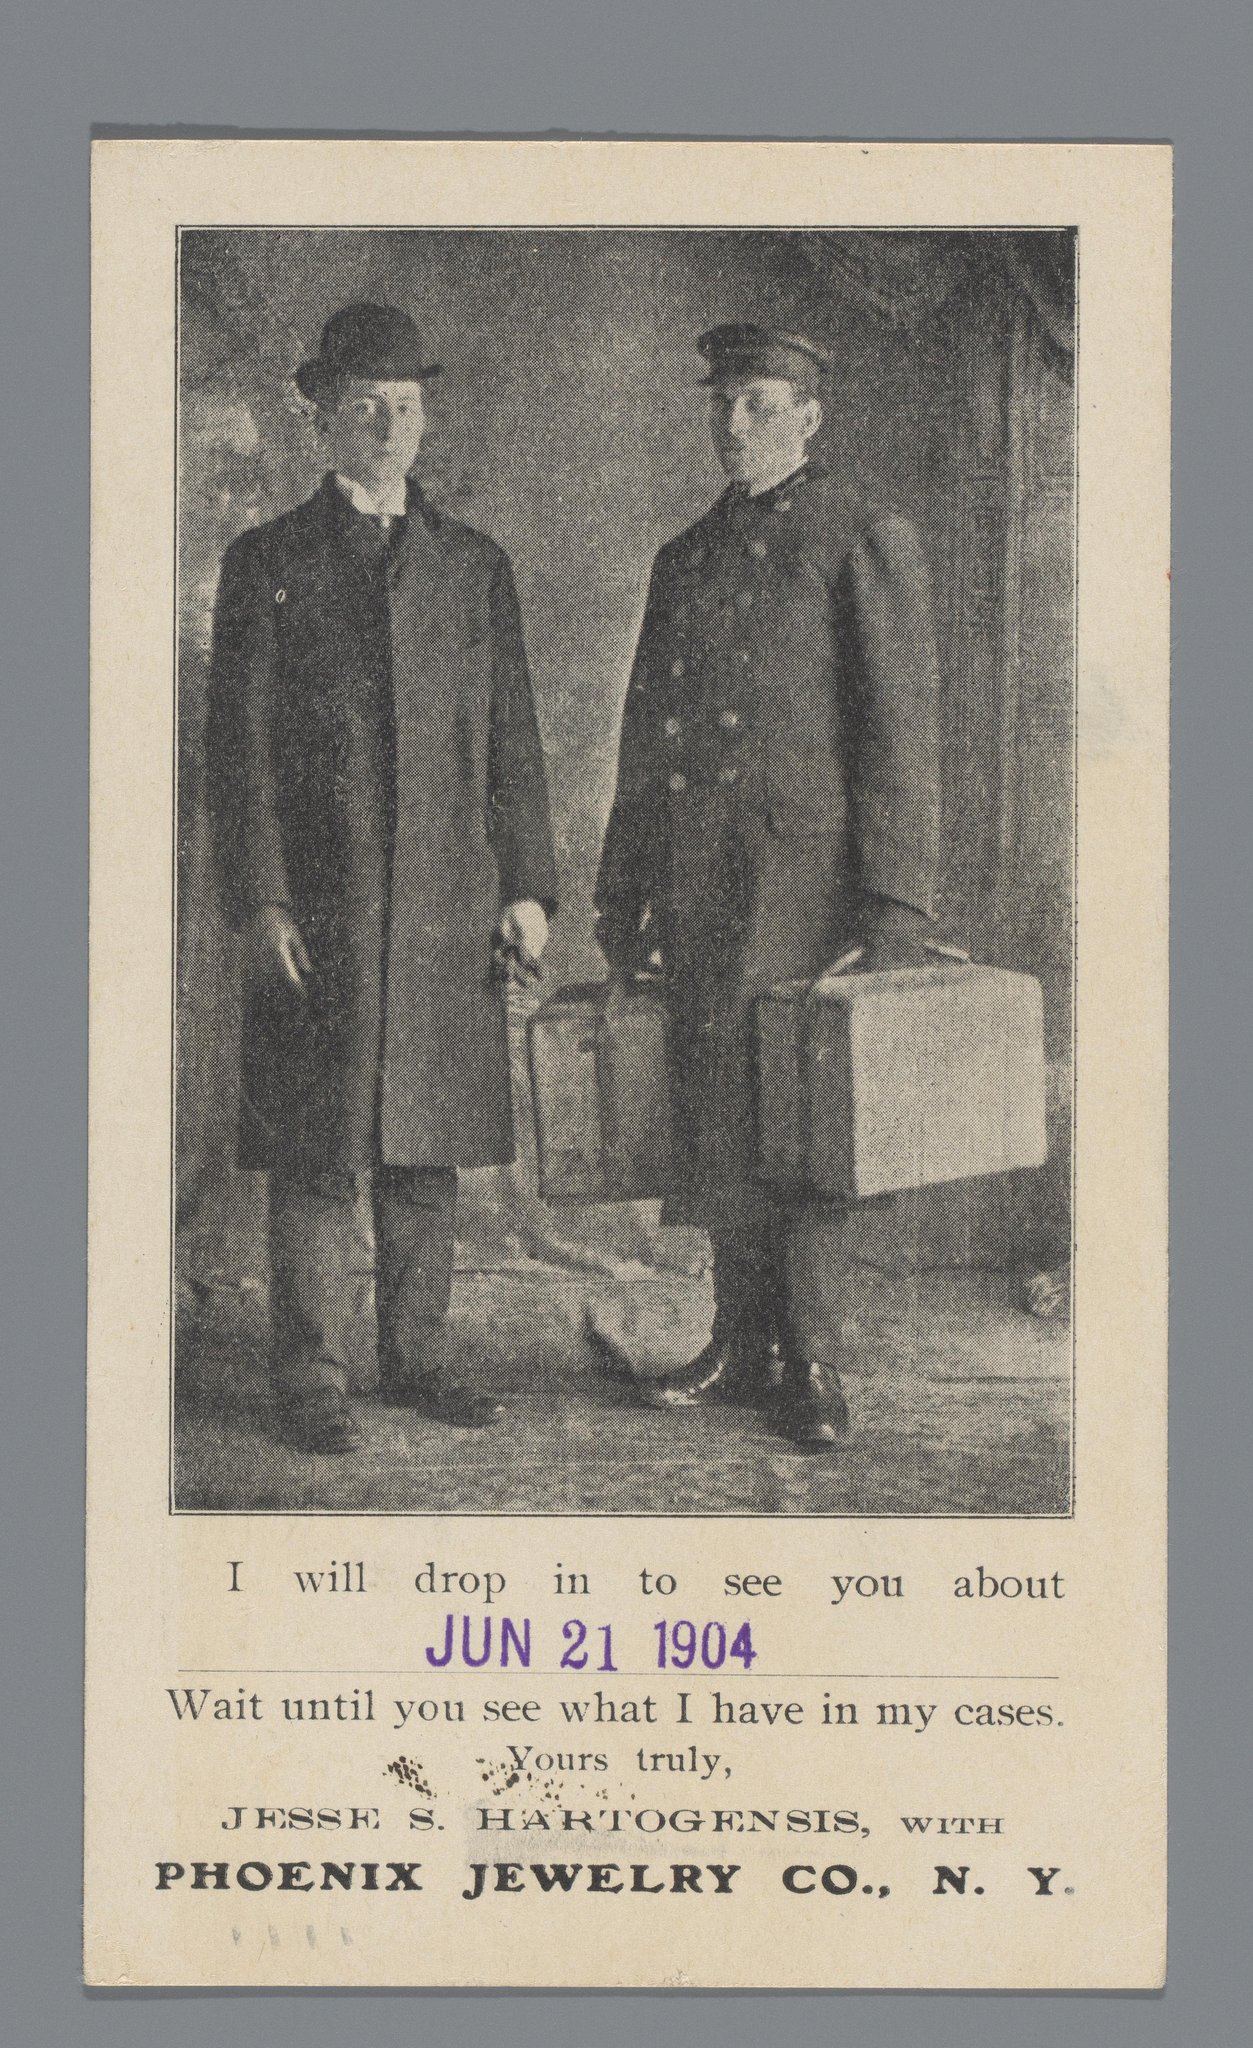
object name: ansichtkaart, prentbriefkaart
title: Reclame voor een juwelier met aankondiging van een bezoek van een vertegenwoordiger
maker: Anonymous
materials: photographic support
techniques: autotype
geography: united states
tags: united states of america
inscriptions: stamp: ‘1904’, inscription: ‘Mr. J. Kashman, / Hartford, / Conn.’, inscription: ‘I will drop in to see you about [gestempeld: JUN 21 1904] Wait until you see what I have in my cases / Yours truly, / JESSE S. HARTOGENSIS, with / PHOENIX JEWELRY CO., N. Y.’